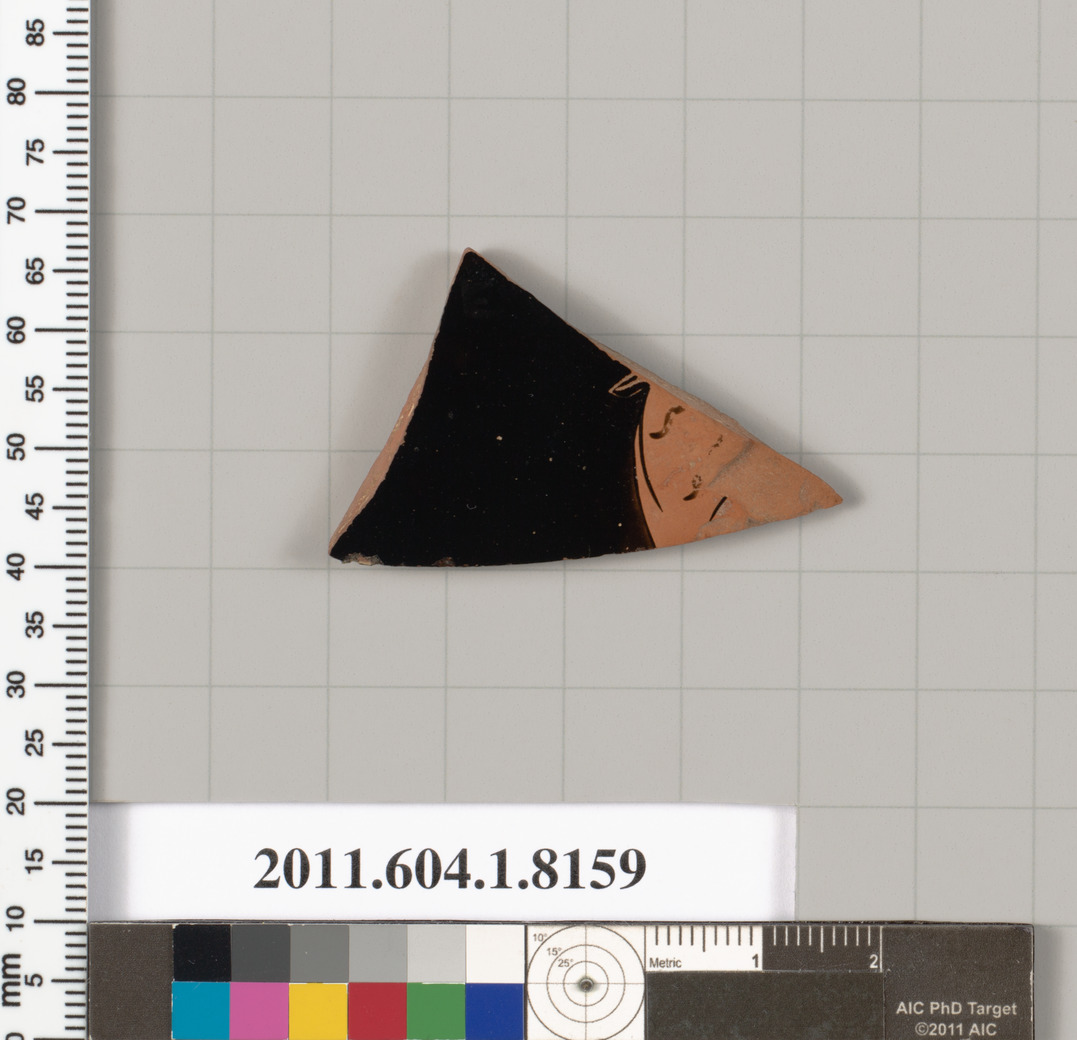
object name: kylix fragment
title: Terracotta fragment of a kylix (drinking cup)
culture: greek, attic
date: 520-500 BCE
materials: terracotta